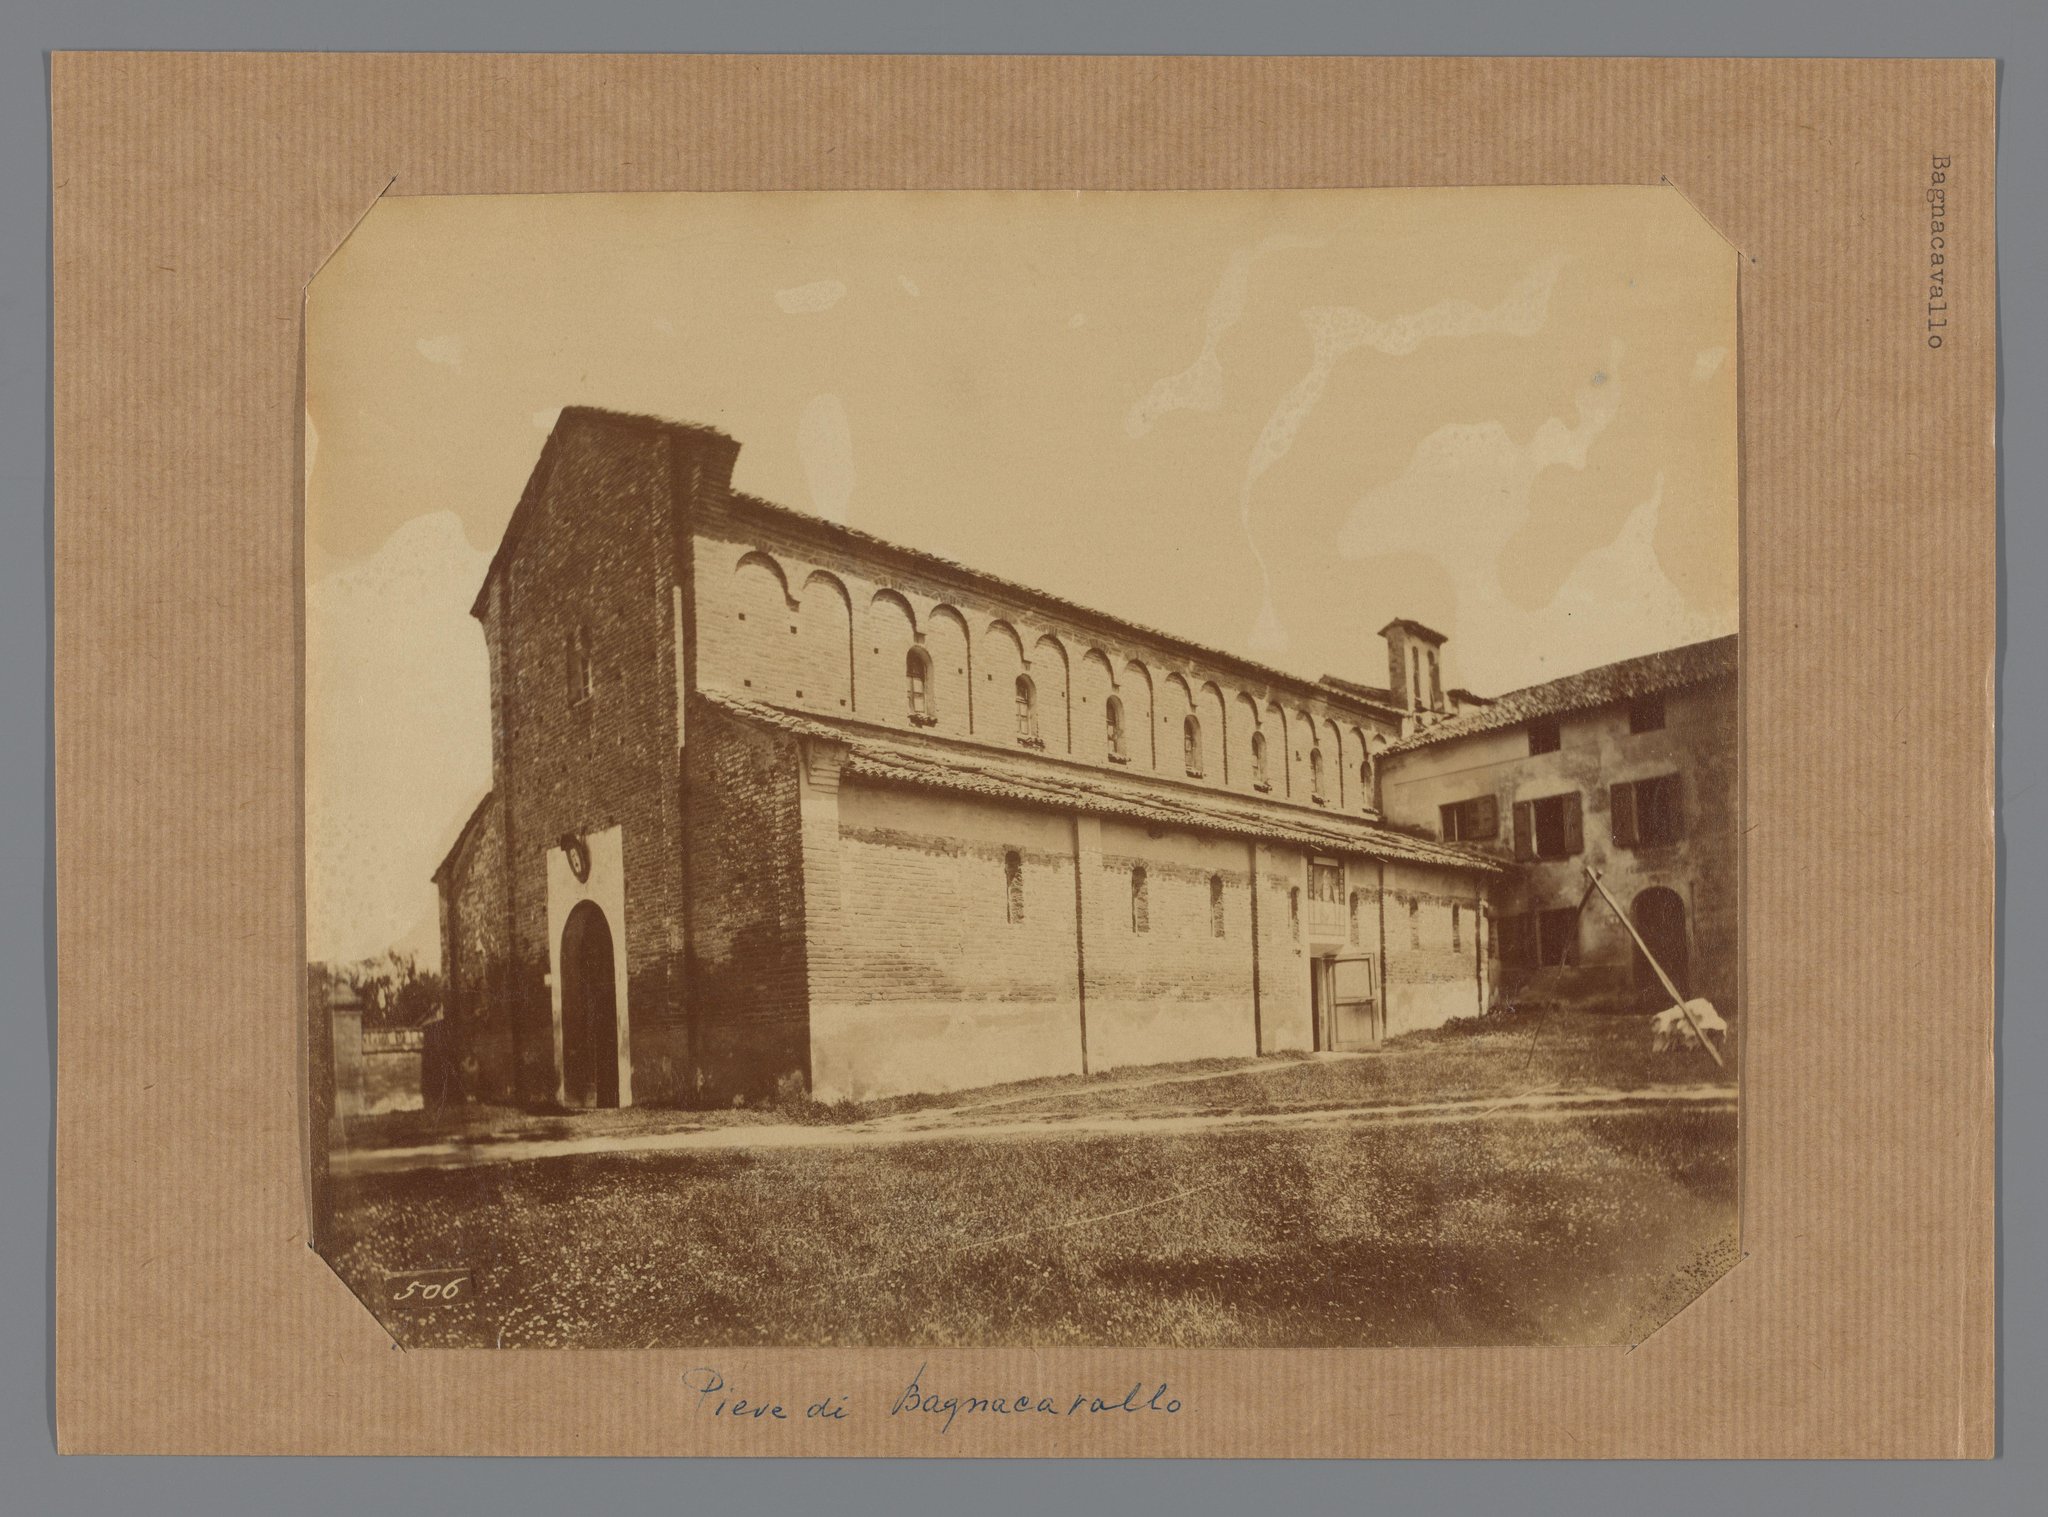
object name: photograph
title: Italië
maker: Anonymous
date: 1880-1910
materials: photographic support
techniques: albumen print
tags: italy